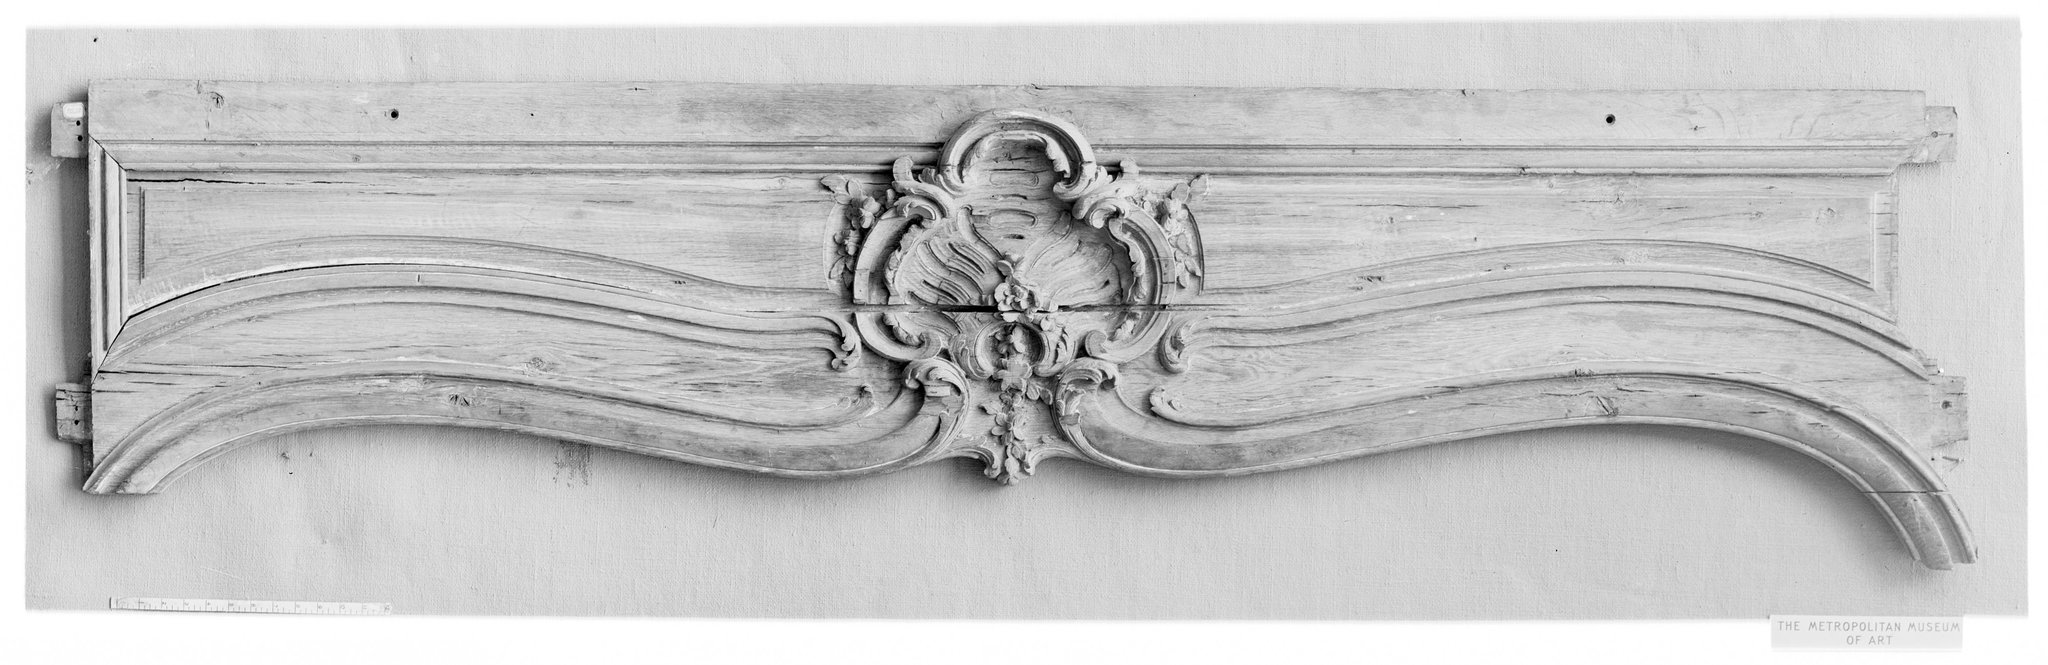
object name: panel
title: Panel (Dessus d'alcove)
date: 1701-1800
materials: wood